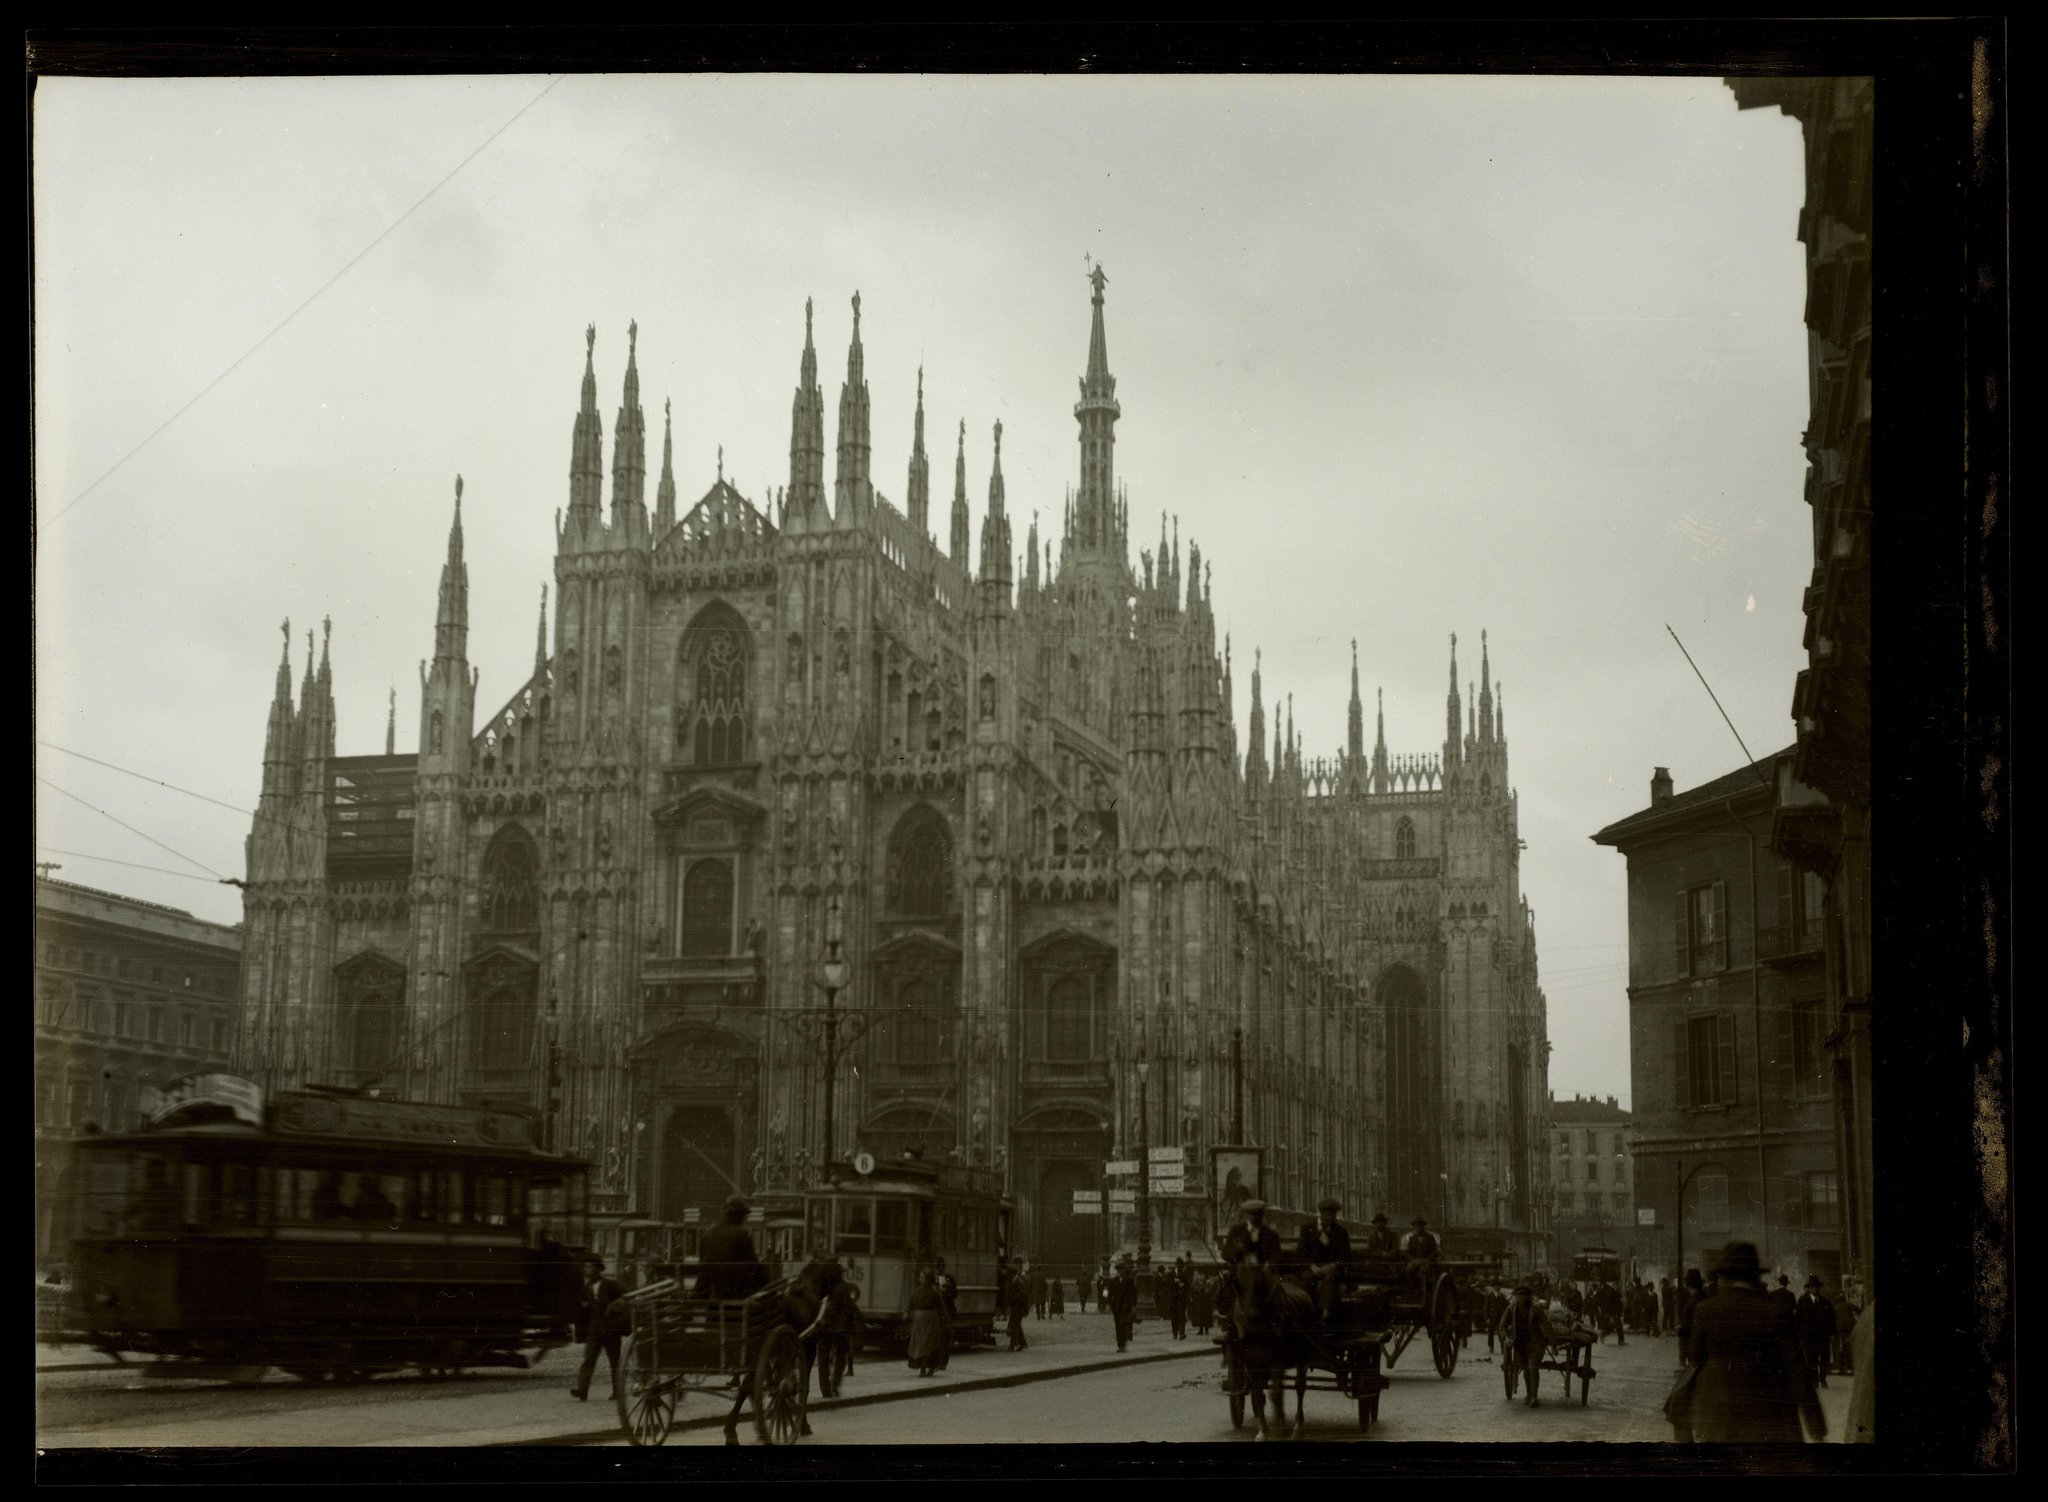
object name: negative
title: Filmnegatief met opname van Genua, Pisa, Ravenna of Milaan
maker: Anonymous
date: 1907-1935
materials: film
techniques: gelatin silver negative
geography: italy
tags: italy